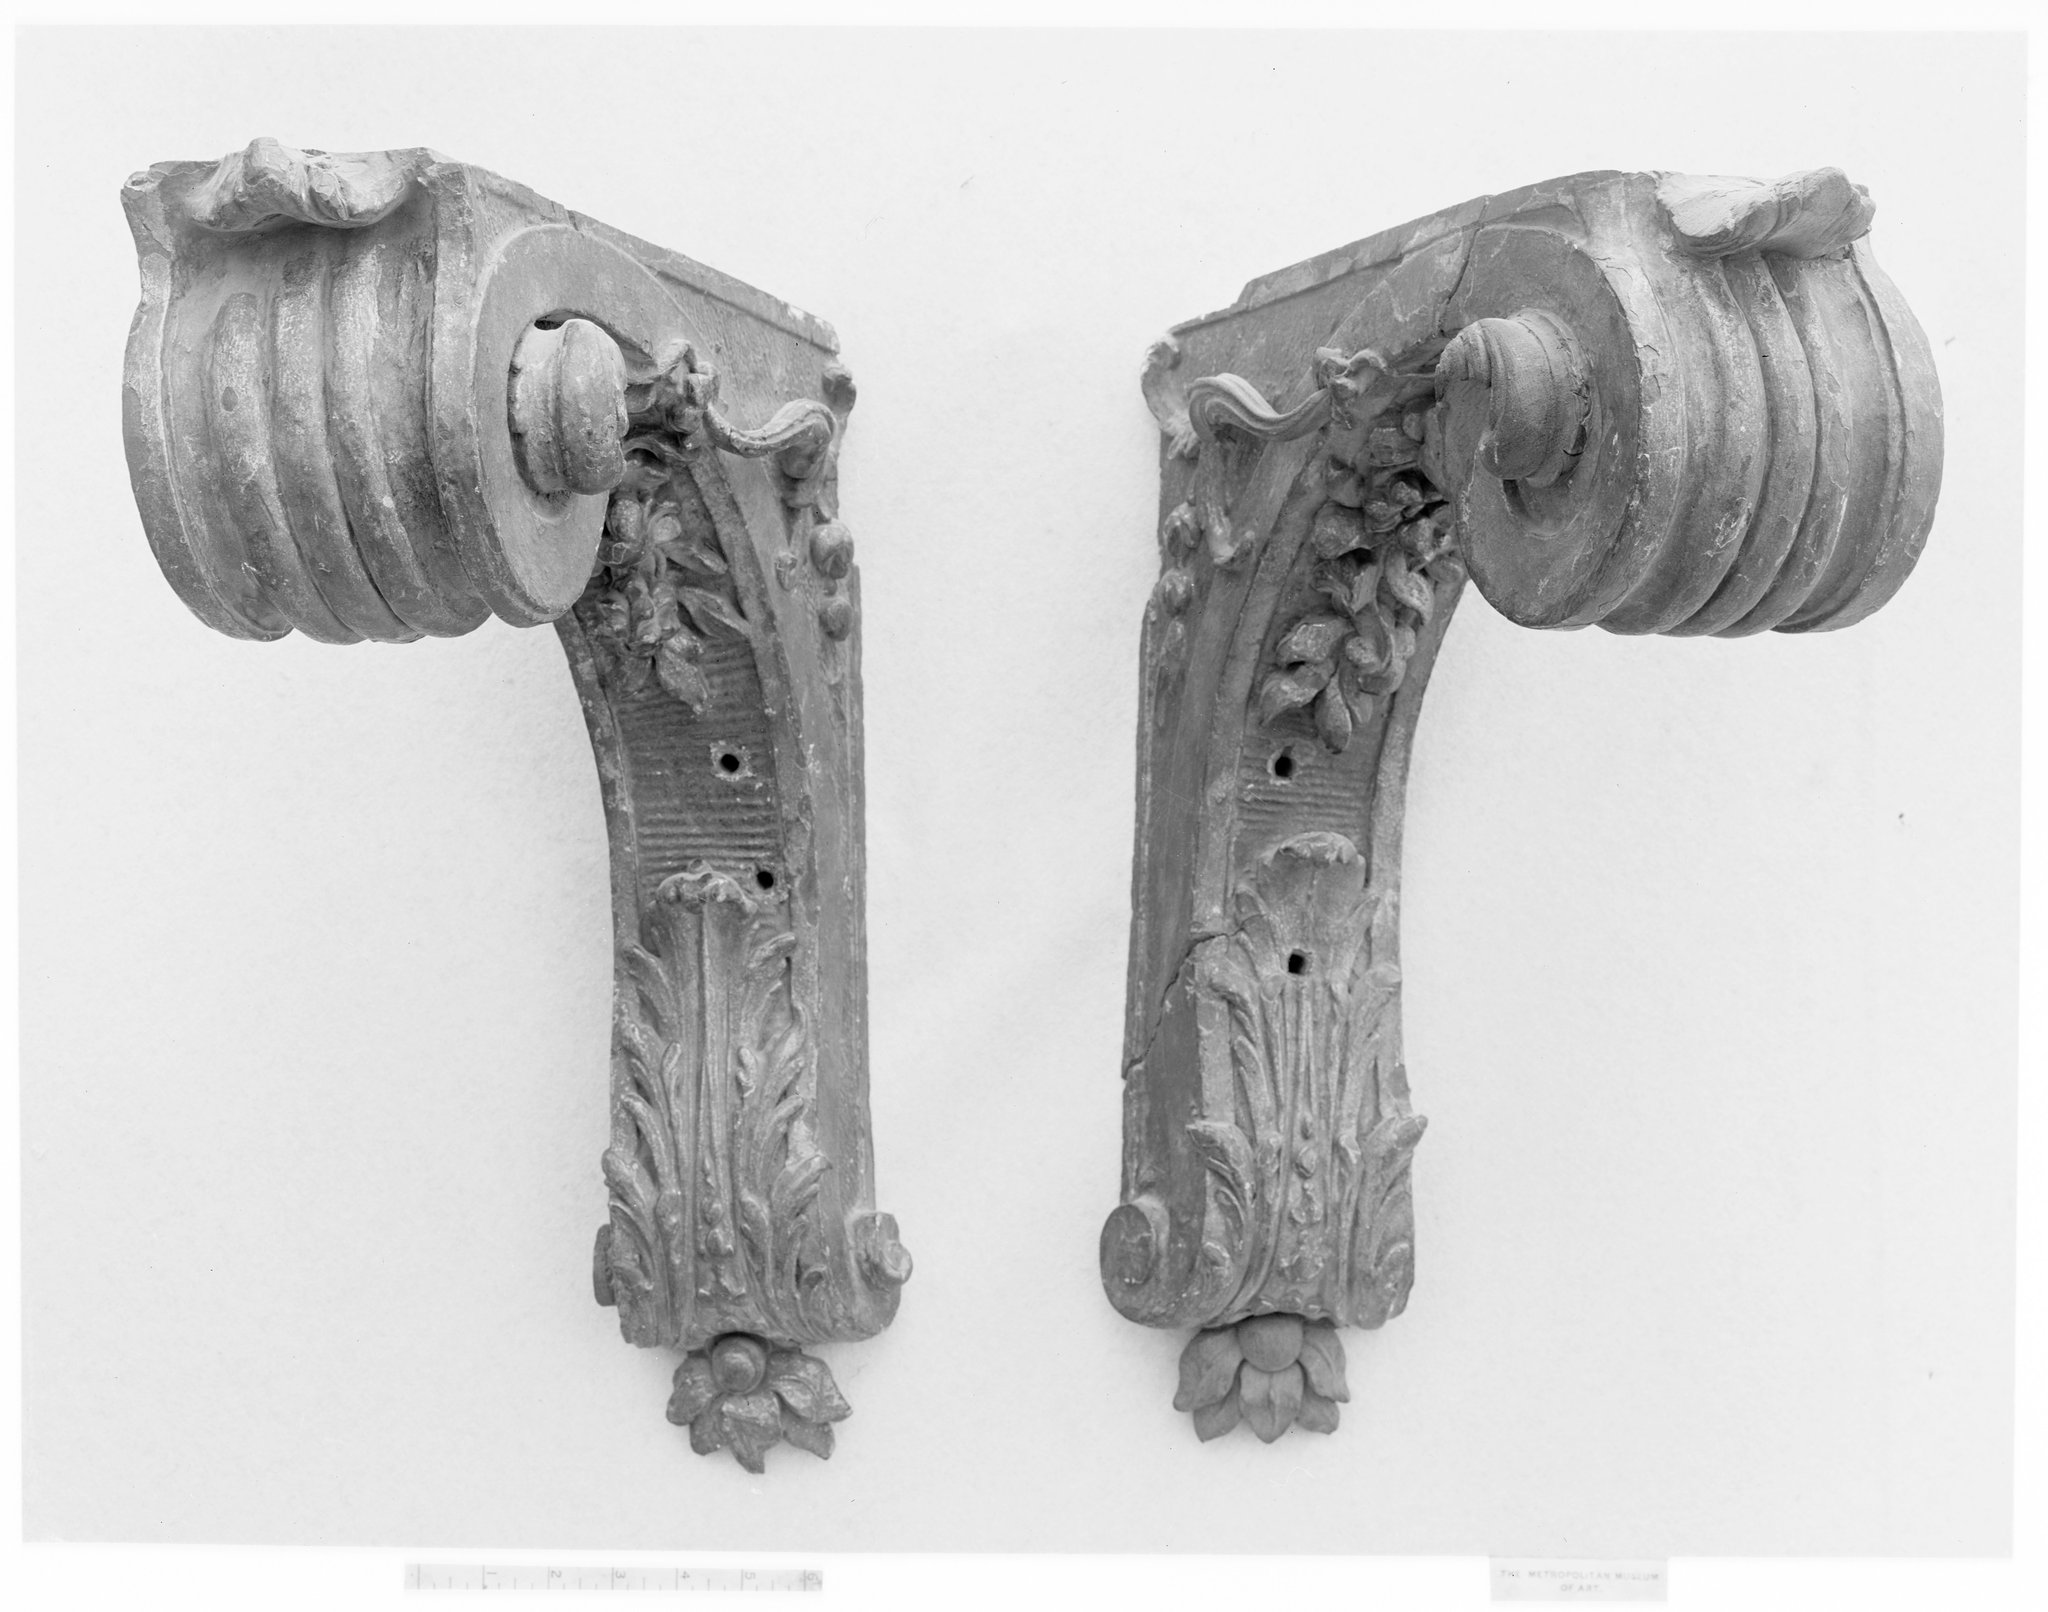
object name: console support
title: Pair of console supports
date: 1701-1733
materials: gilt, wood